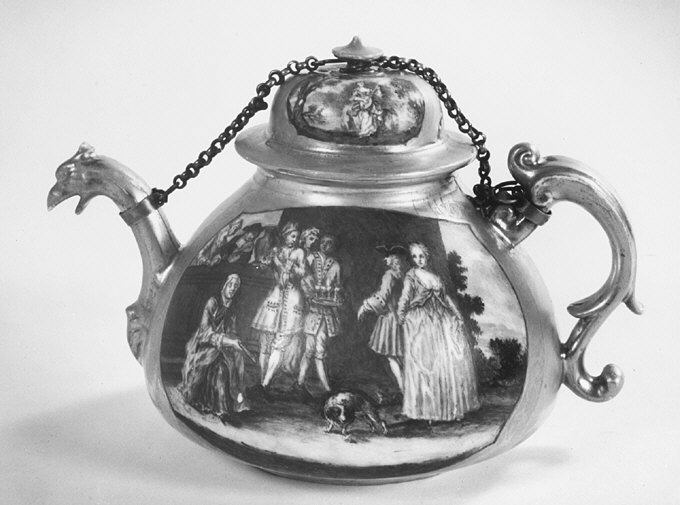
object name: teapot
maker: meissen manufactory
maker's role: manufactory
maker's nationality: german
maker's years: 1710-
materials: hard paste porcelain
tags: men,women,dogs